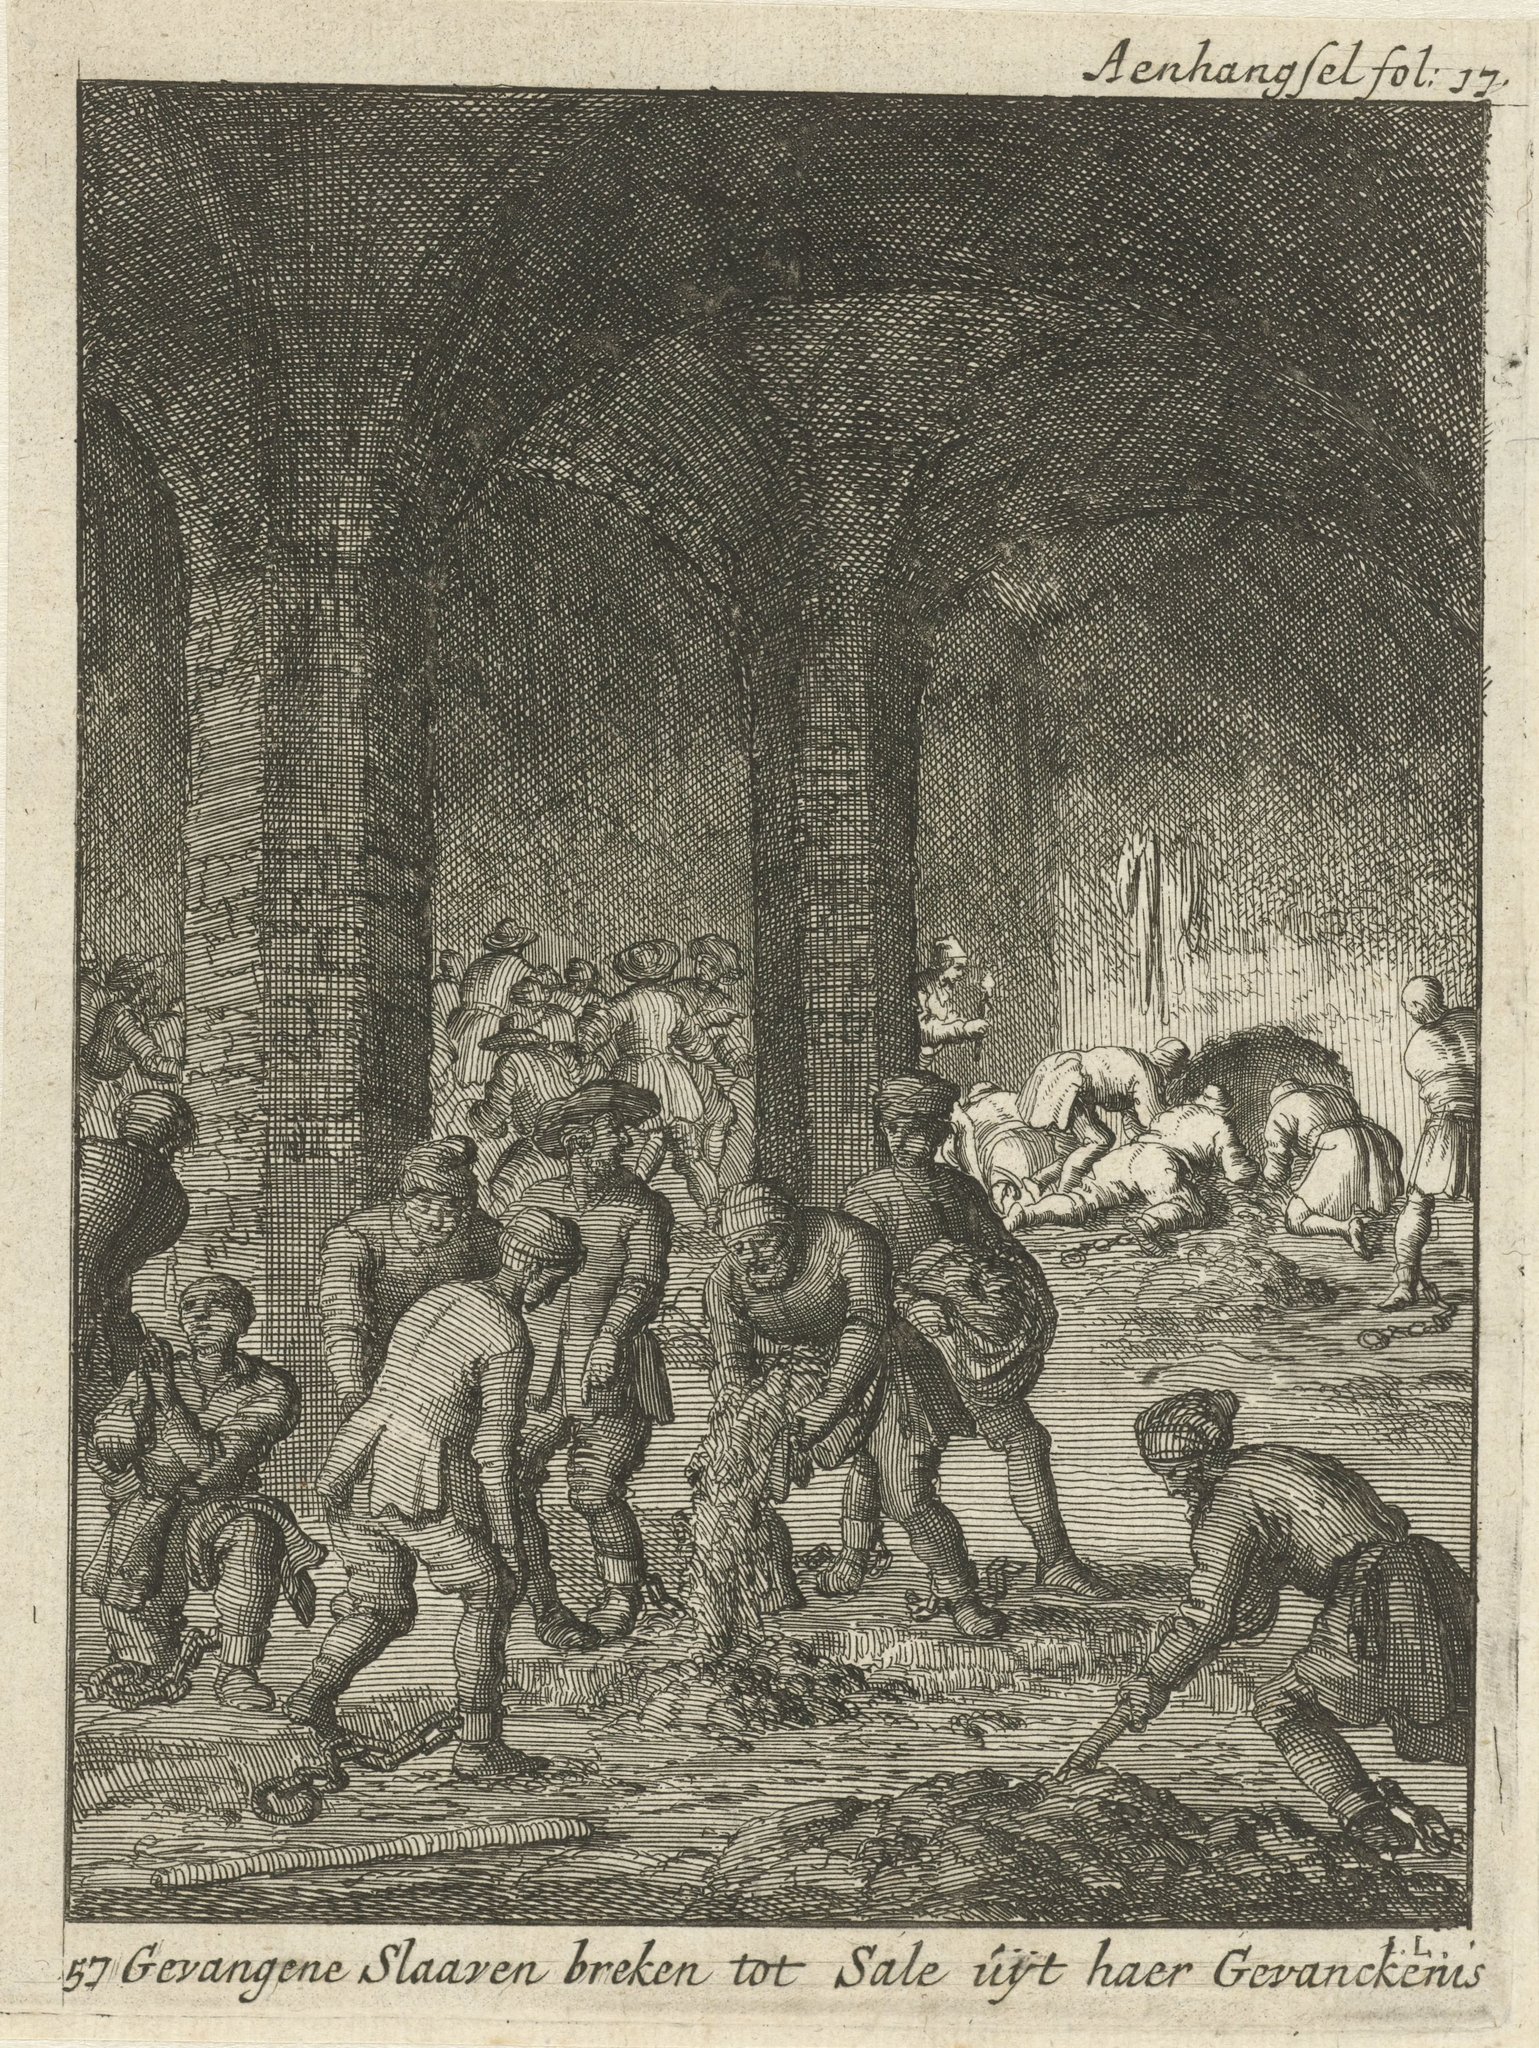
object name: book illustration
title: 57 Gevangene Slaaven breken tot Sale uijt haer Gevanckenis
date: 1684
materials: paper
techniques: engraving, etching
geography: amsterdam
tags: escape attempts (of an enslaved person)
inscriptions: collector's mark: Lugt 2228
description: 57 slaafgemaakte christenen in Salé graven een tunnel in de gevangenis waar ze ’s nachts verbleven, 1674. Na 35 nachten graven ontsnapten ze. Rechtsboven gemerkt: Aenhangsel fol: 17.